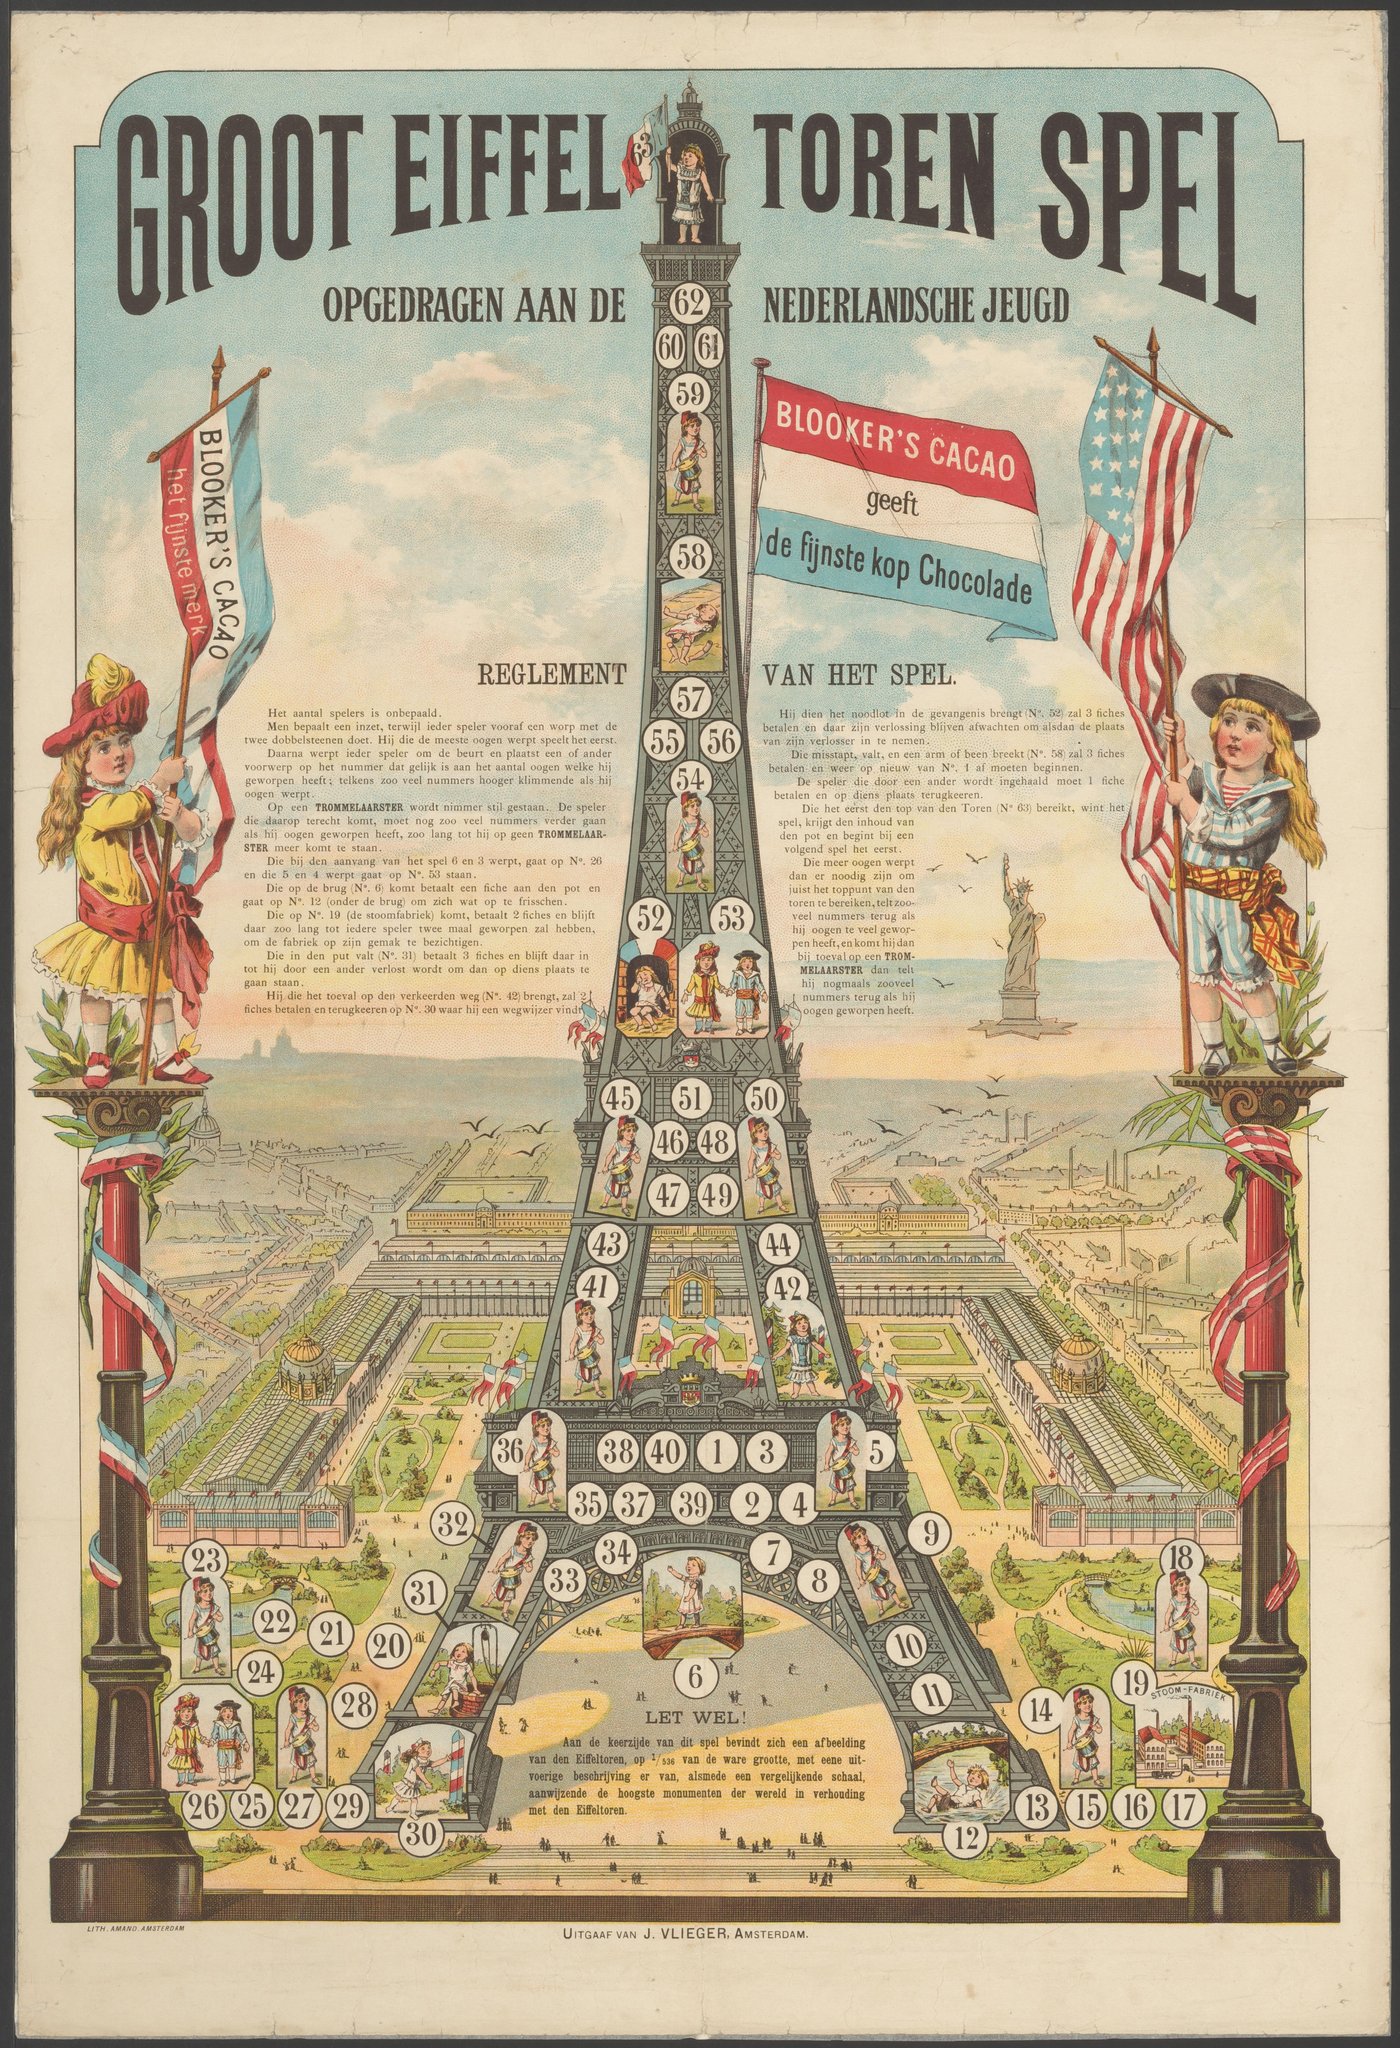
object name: gameboard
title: Groot Eiffel toren spel / opgedragen aan de Nederlandsche jeugd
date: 1889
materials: paper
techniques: lithograph, letterpress printing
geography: amsterdam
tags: goose-game, board-games of chance, board-games, eiffel tower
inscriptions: : ‘Déposé’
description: Bordspel met een afbeelding van de Eiffeltoren en het terrein van de Wereldtentoonstelling in Parijs van 1889. Op en naast de toren de vakken genummerd van 1 tot 63. Uit de toren hangt de Nederlandse vlag met de tekst 'Blooker's cacao geeft de fijnste kop Chocolade'. Vak 19 toont Blooker's stoomfabriek. Links een zuil met erboven op een meisje met de Franse vlag met de tekst 'Blooker's cacao het fijnste merk' en rechts een zuil met een meisje met de Amerikaanse vlag. Rechts op de achtergrond het Vrijheidsbeeld. Midden op het blad de spelregels. Verso een afbeelding van de Eiffeltoren op 1/536 van de ware grootte met een beschrijving en een vergelijking met andere hoge gebouwen. Onderwerpsrubrieken binnen de Atlas Zeden en Gewoonten: Zeden en gewoonten in engeren zin, Spel en vermaak, Gezelschapsspel II, Ganzenbord en dergelijke.